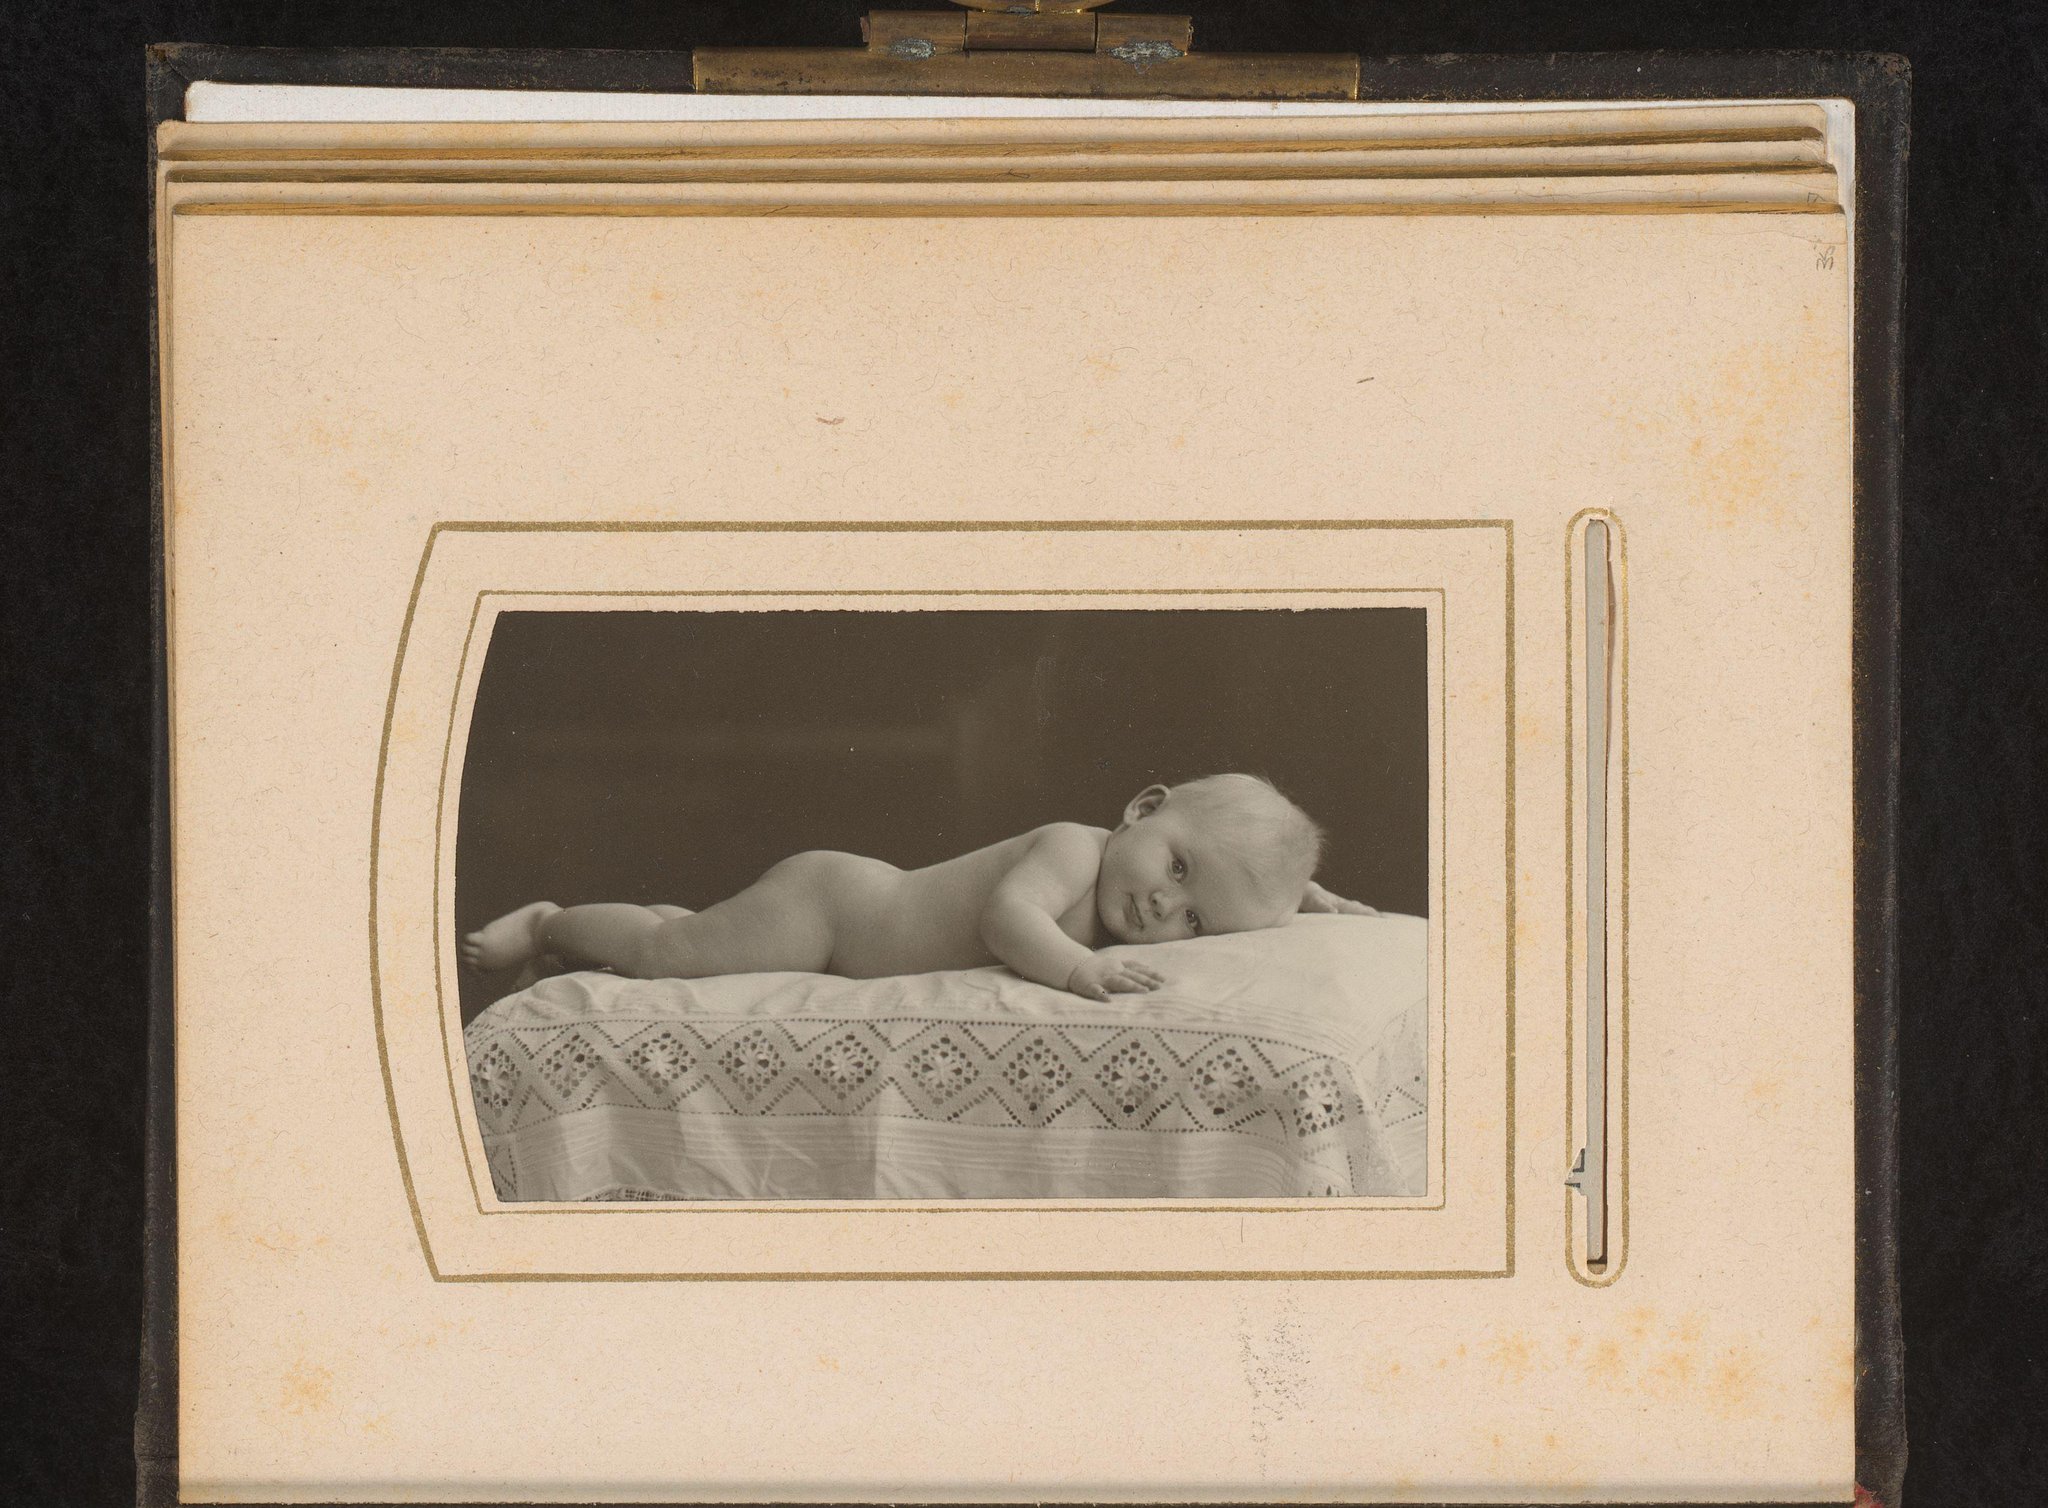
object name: carte de visite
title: Portret van een baby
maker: willy dose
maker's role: fotograaf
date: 1900-1910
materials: cardboard, photographic support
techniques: collodion silver print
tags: historical persons, infant, baby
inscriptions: inscription: ‘(...)/ Willy Dose/ Atelier für mo/ derne bildnisse/ Bremen/ Wall 117/ (...)’